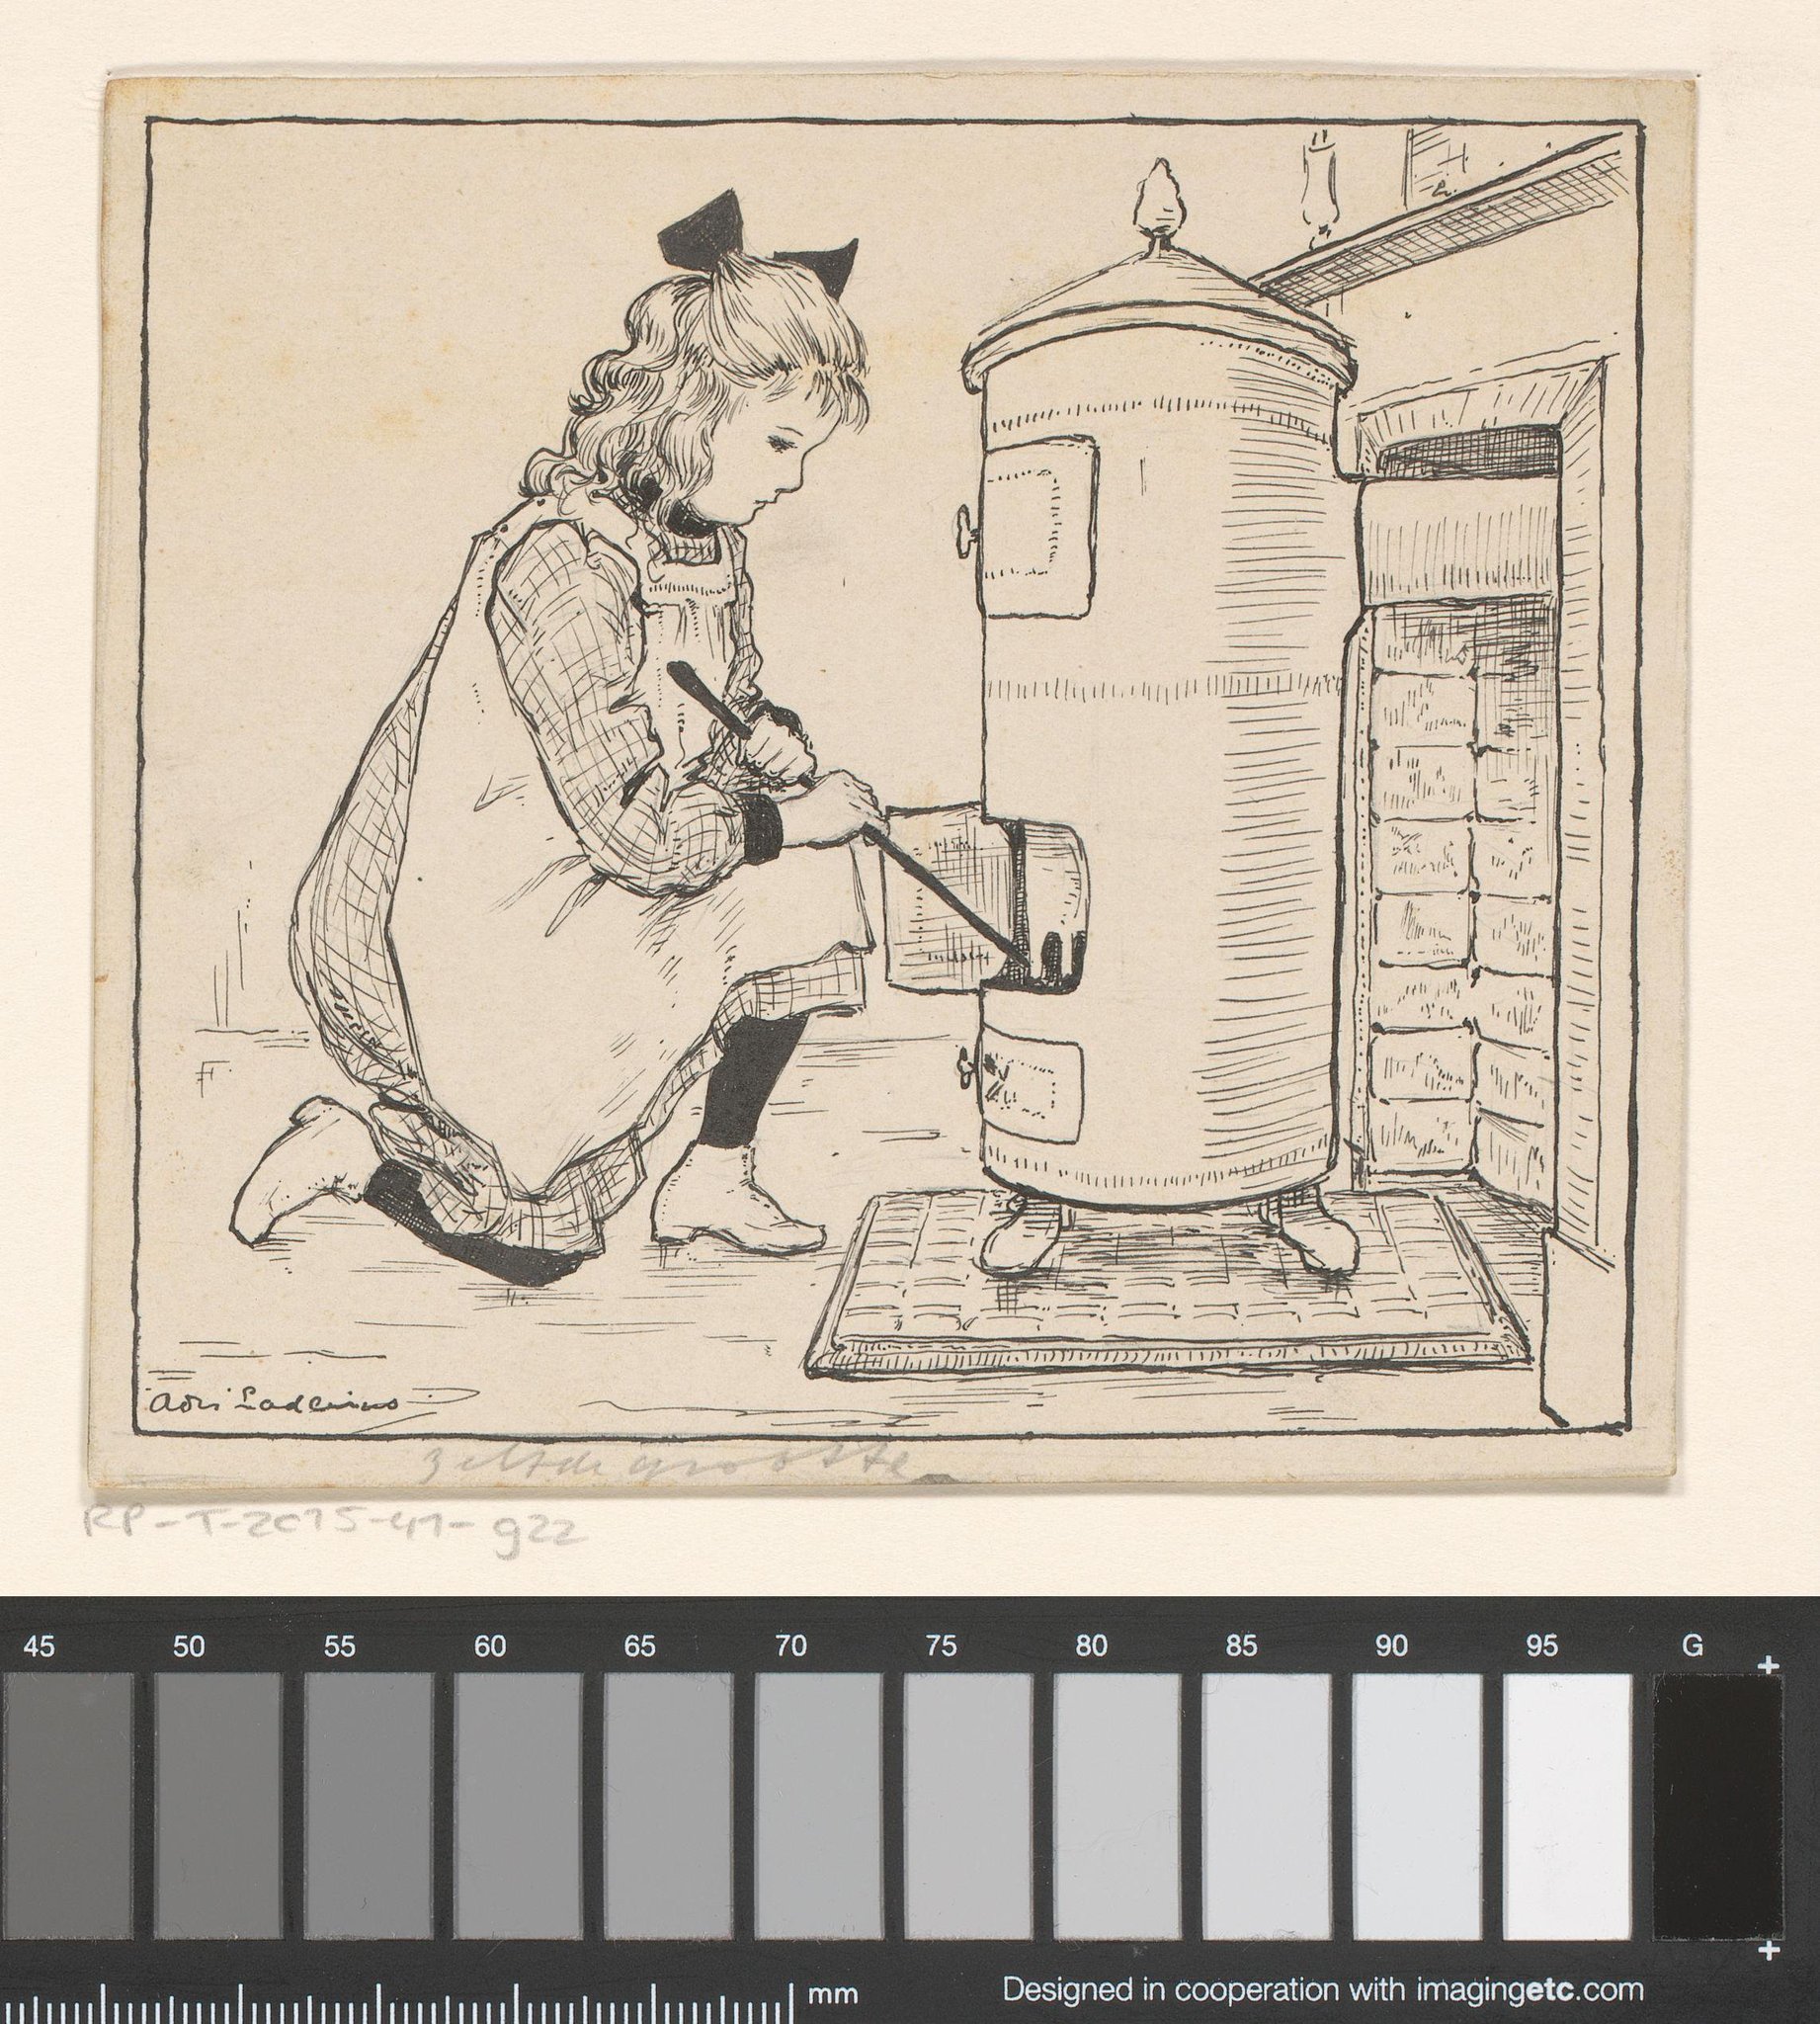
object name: boekillustratie ontwerp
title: Meisje stookt een kachel op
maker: adri ladenius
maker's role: draughtsman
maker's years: 1883-1953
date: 1893-1953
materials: ink, paper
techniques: pen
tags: kneeling figure - aa - female human figure, heating stove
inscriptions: annotation: ‘II/ "Laat mij maar! Waar is de pook?"/ Lies aan 't poken. Rrr! rrr! rrr!/ Mooi zo!’, signature: ‘Adri Ladenius’, collector's mark: Lugt 2228, :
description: Een meisje zit geknield voor een kachel en stookt deze op met een pook.